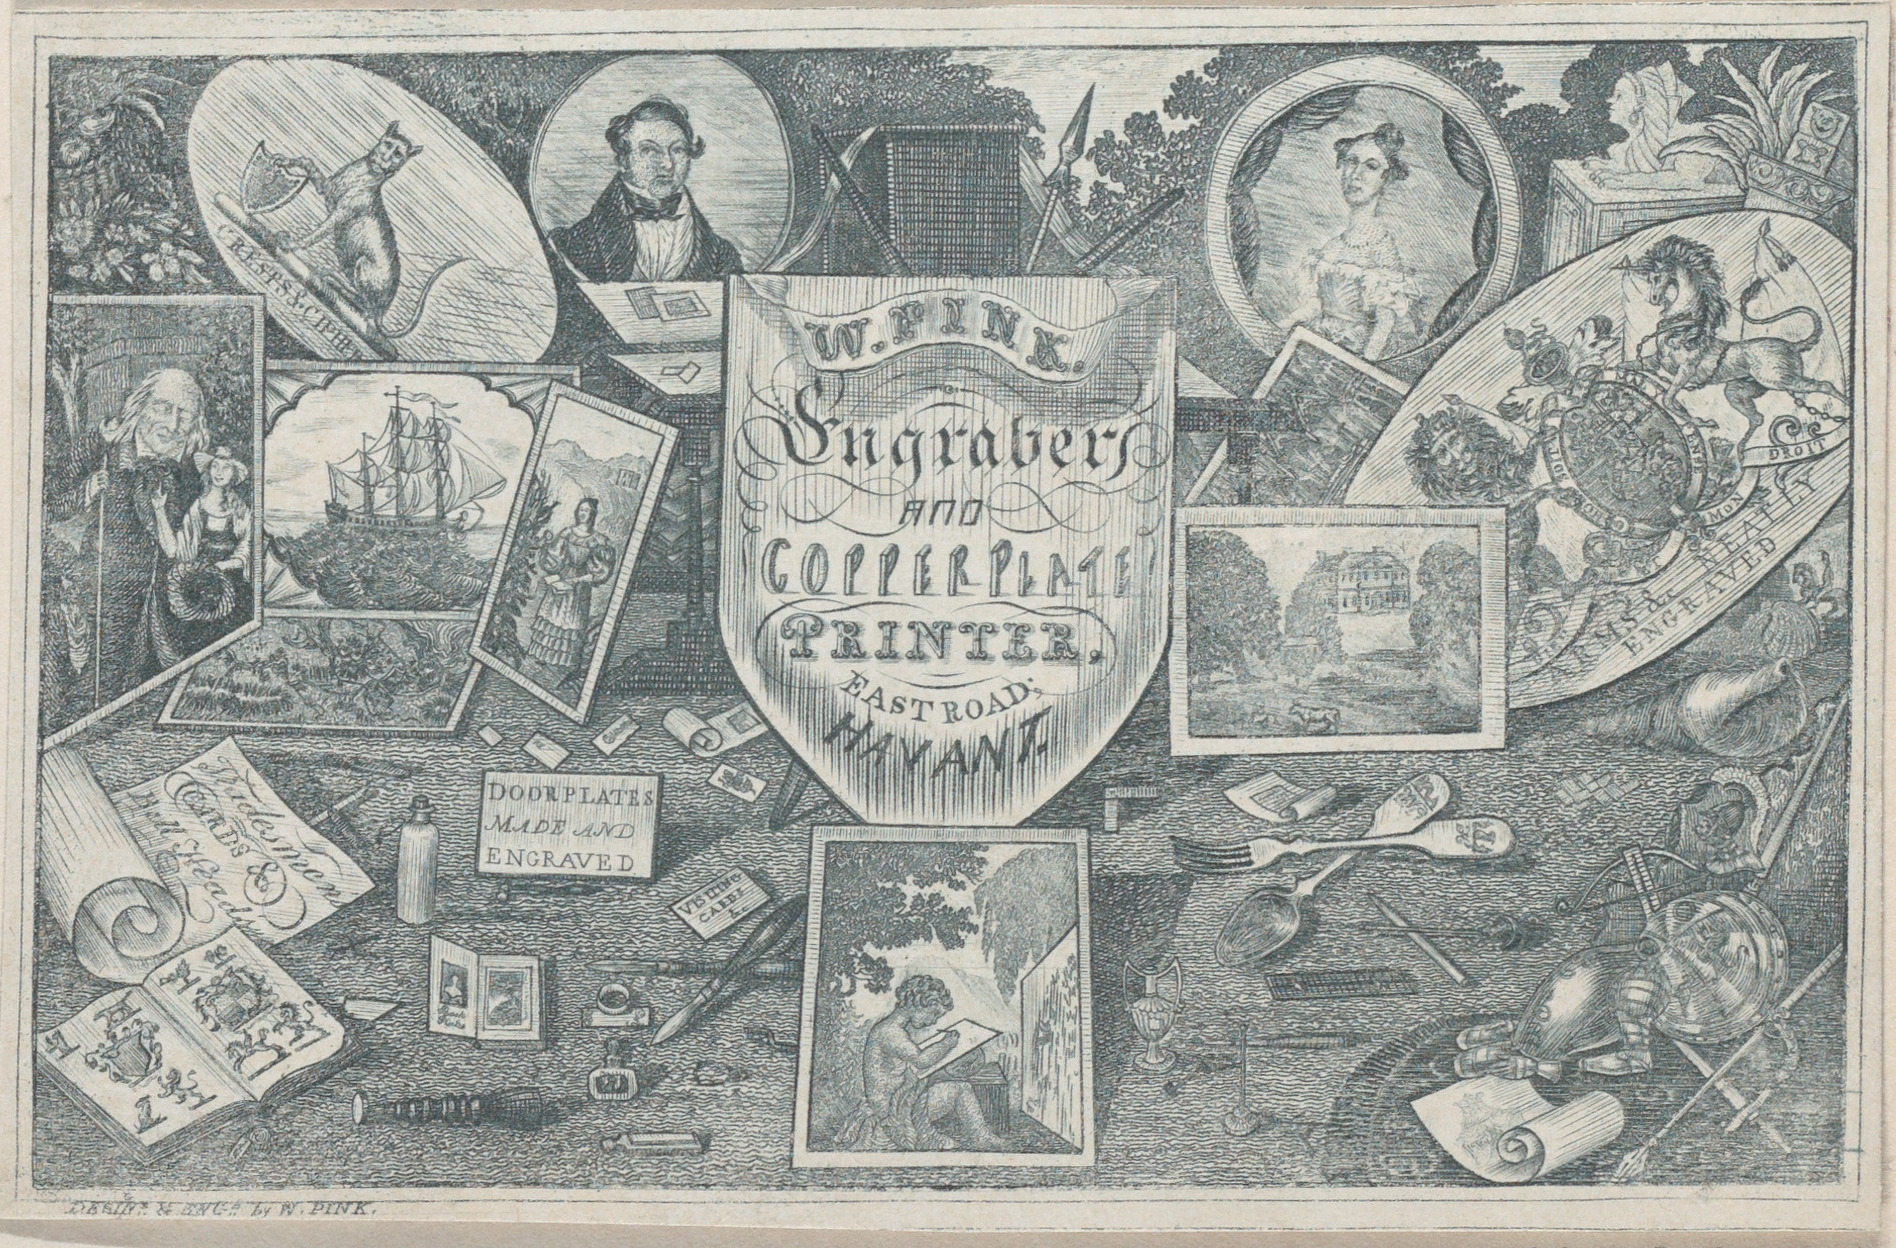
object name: print, trade card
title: Trade Card for W. Pink, Engraver and Printer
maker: w. pink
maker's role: engraver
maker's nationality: british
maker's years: 1800-1900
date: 1801-1900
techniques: engraving